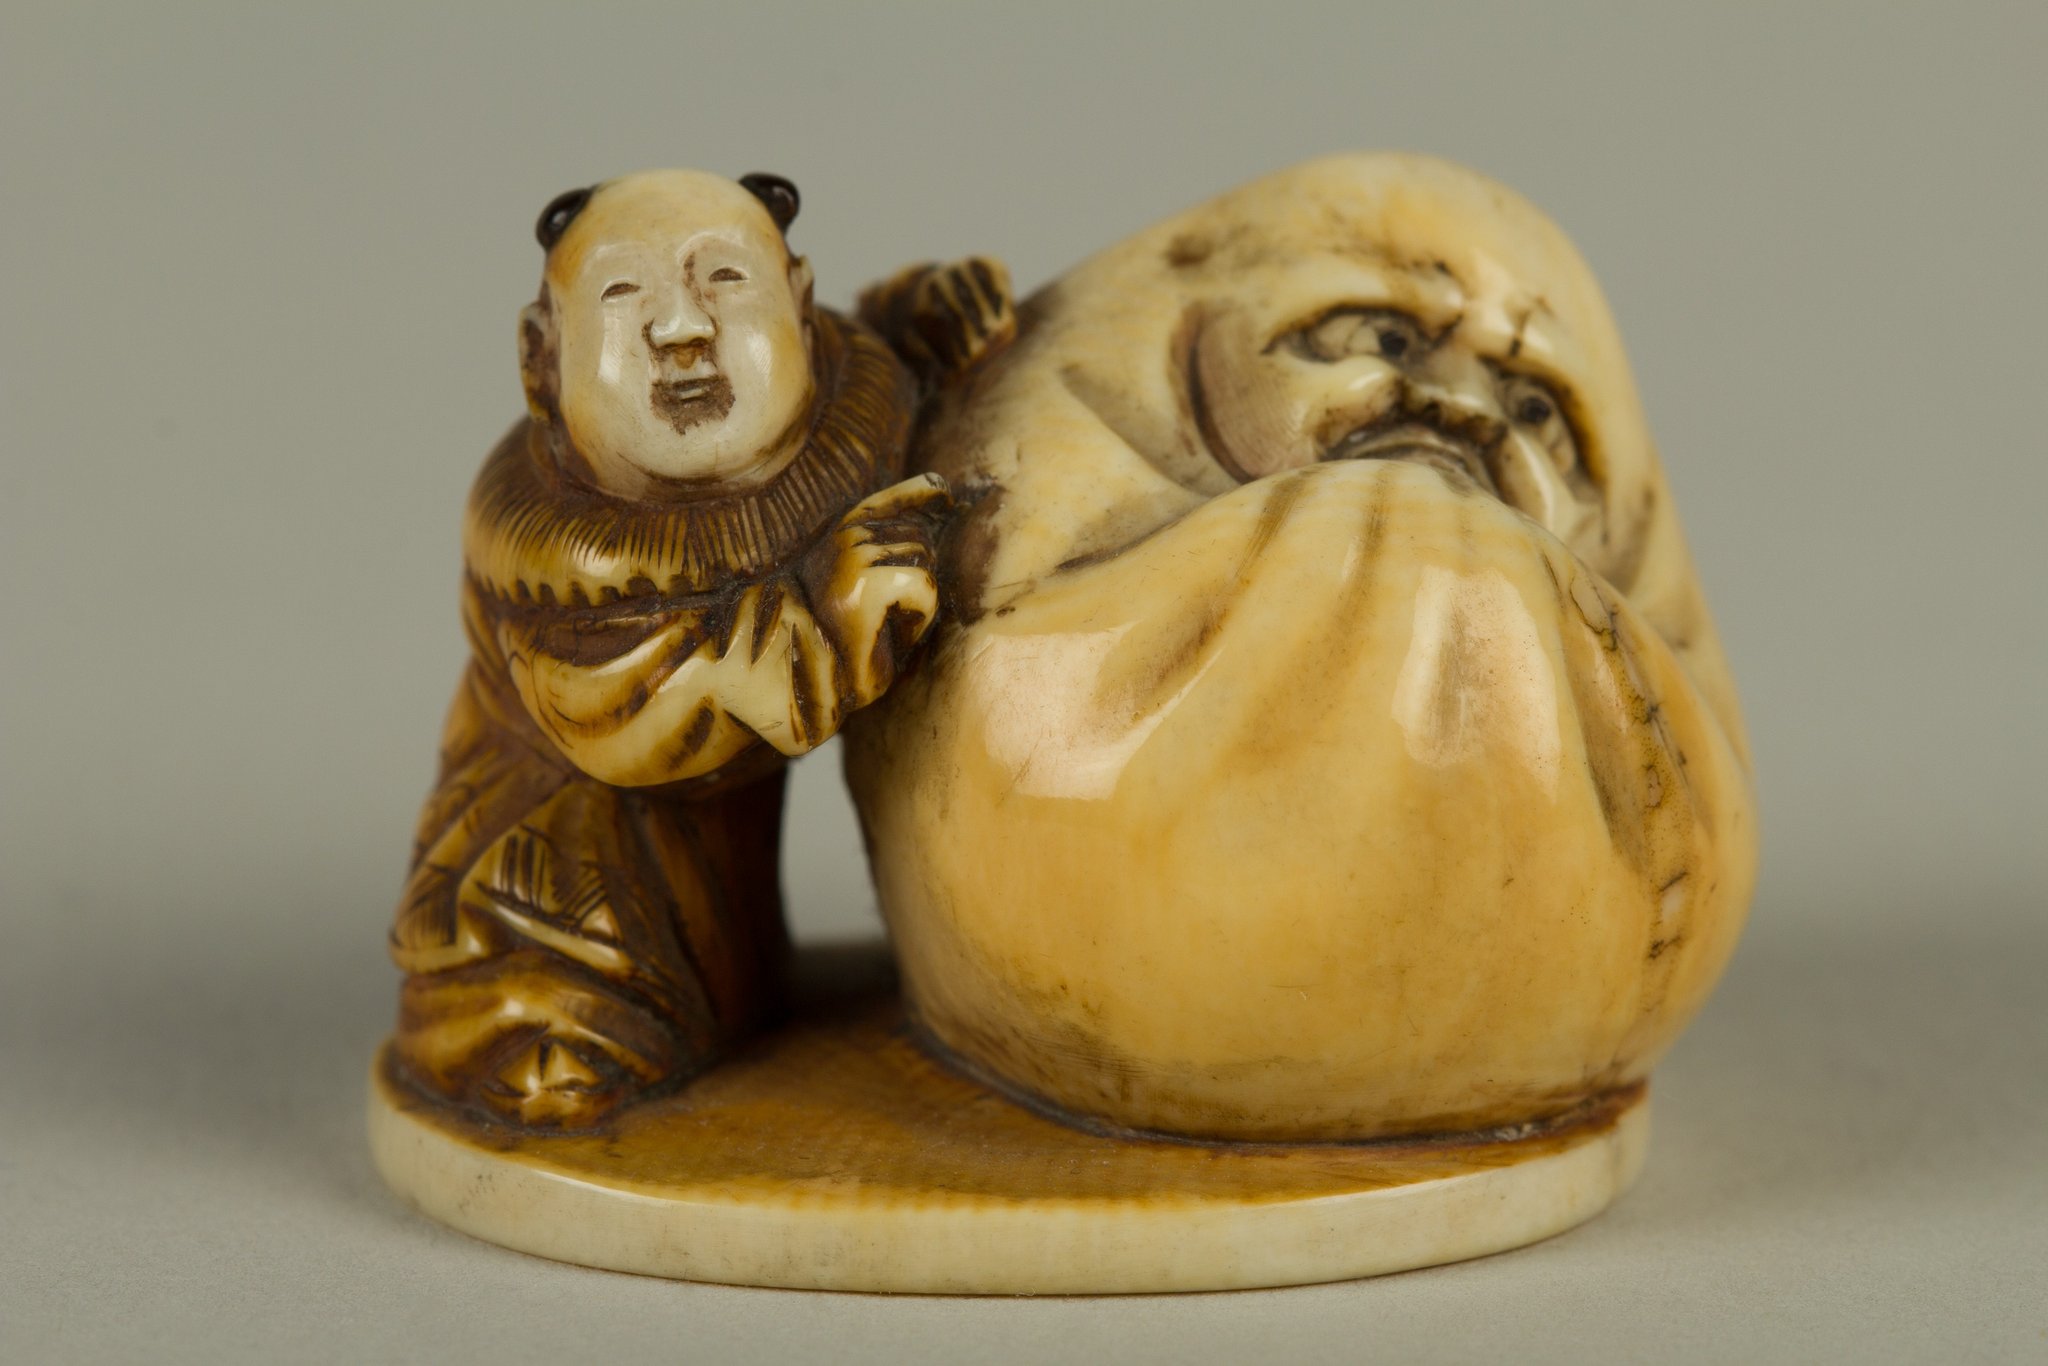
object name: netsuke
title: Netsuke of Dharma with a Small Boy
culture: japanese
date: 1801-1900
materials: ivory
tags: boys